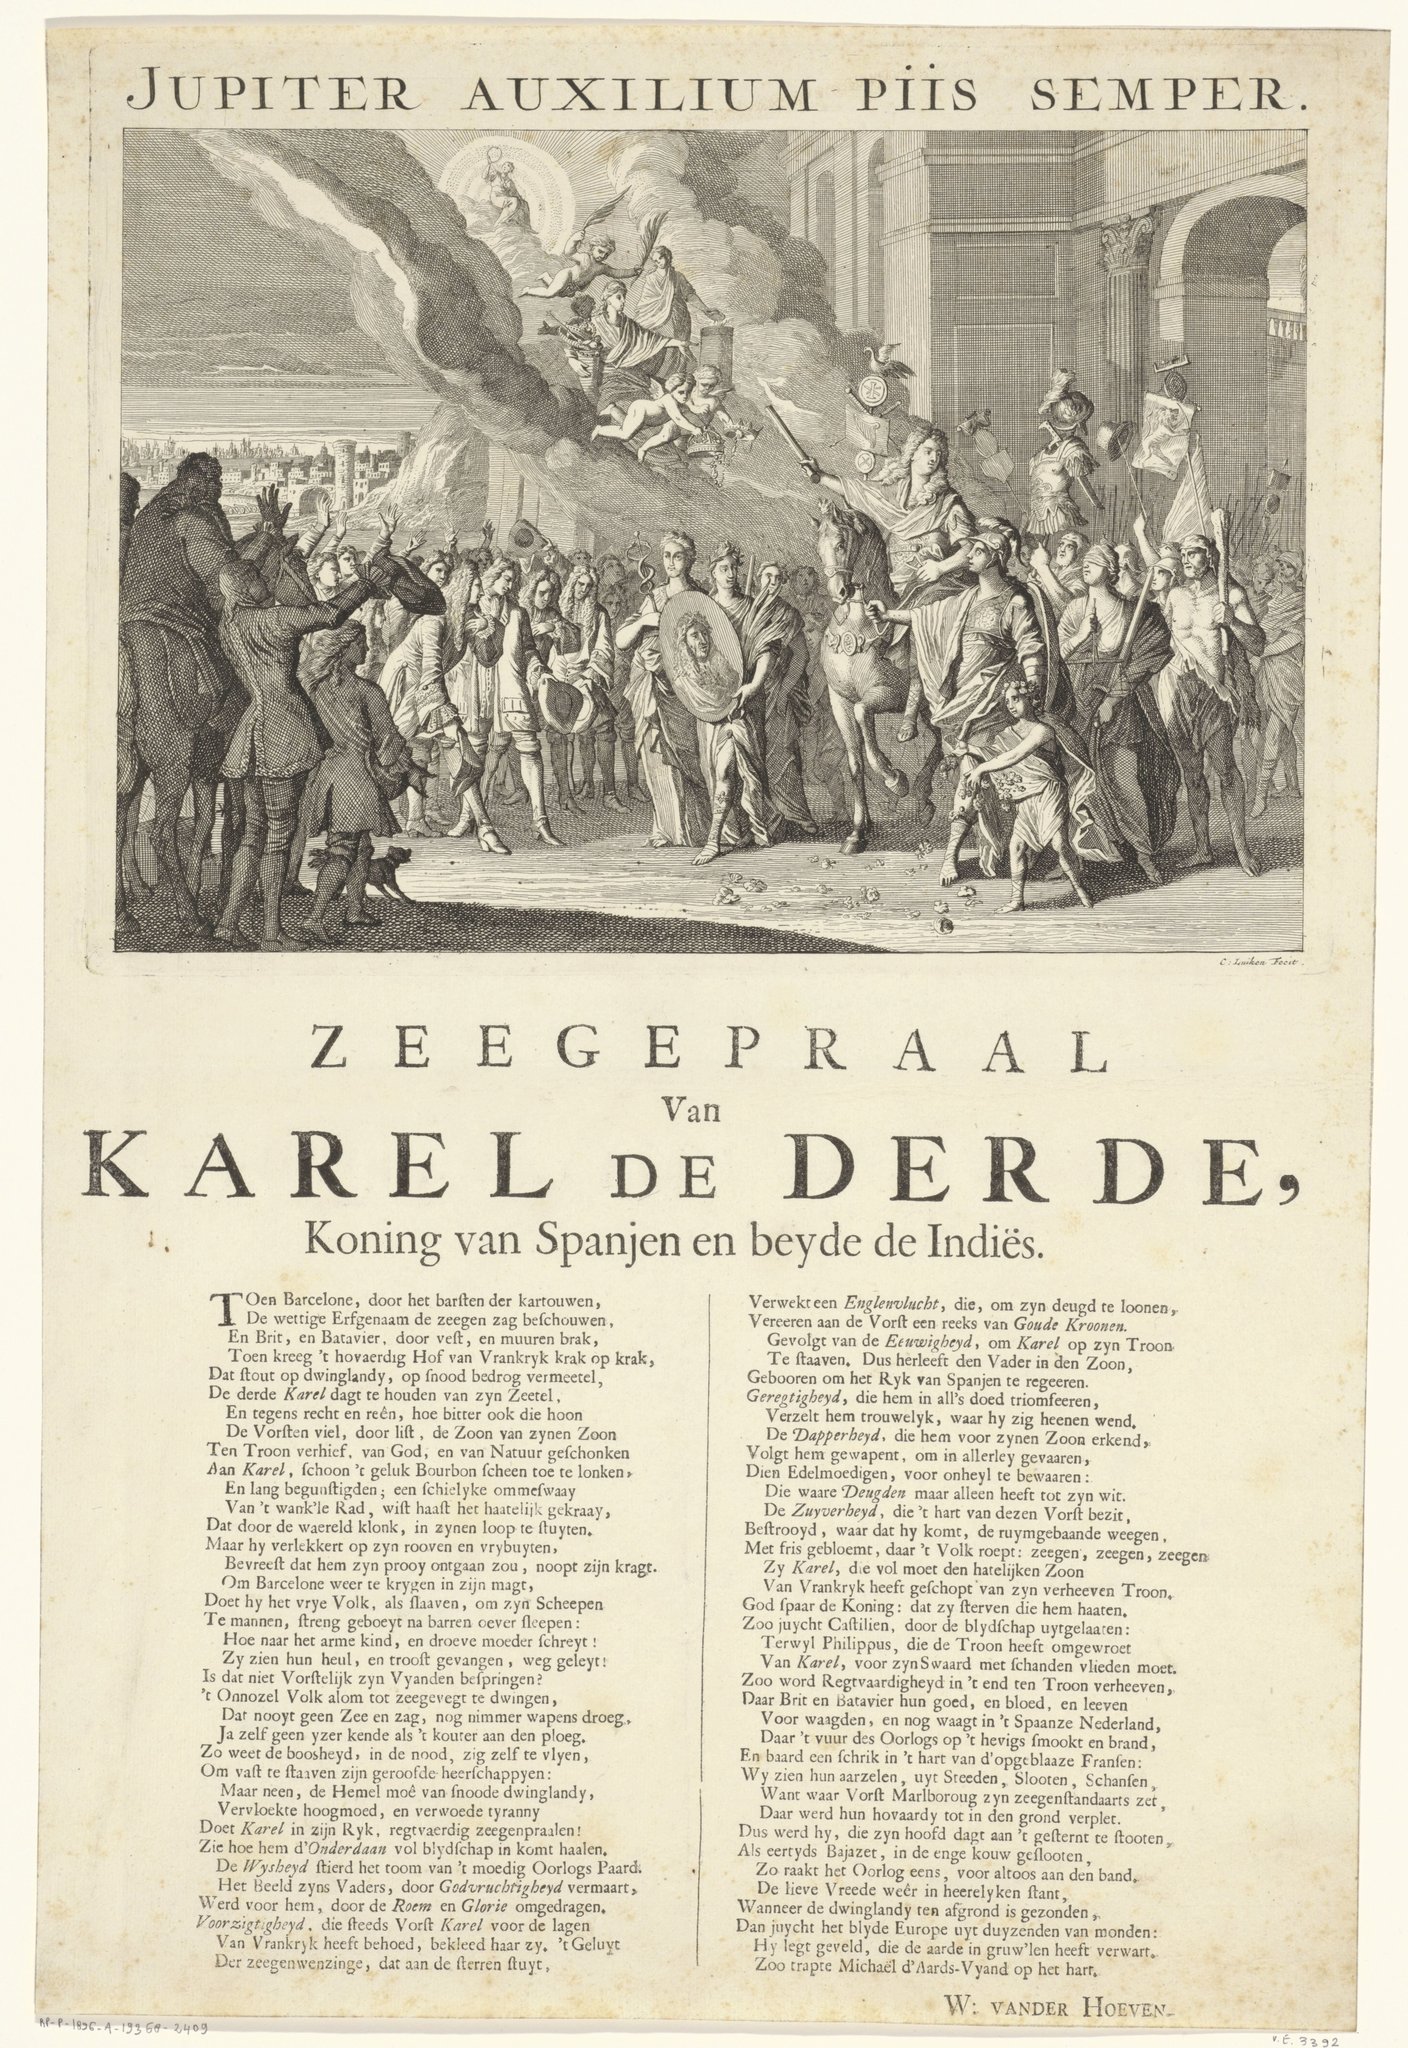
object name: propagandaprent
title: Allegorie op intocht van aartshertog Karel als koning Karel III van Spanje te Barcelona, 1705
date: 1705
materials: paper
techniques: etching, letterpress printing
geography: amsterdam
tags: vienna, charles vi (holy roman emperor), symbolic triumphs of individual persons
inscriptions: collector's mark: Lugt 2228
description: Allegorie op de intocht van aartshertog Karel van Oostenrijk als koning Karel III van Spanje te Barcelona, oktober 1705. De aartshertog rijdend te paard bij de stadspoort, begeleid door allegorische figuren met een portret van keizer Leopold I en toegejuicht door het volk. In de wolken allegorische figuren en putti met kronen en palmtakken. Gedrukt op het blad onder de plaat een vers in 2 kolommen.